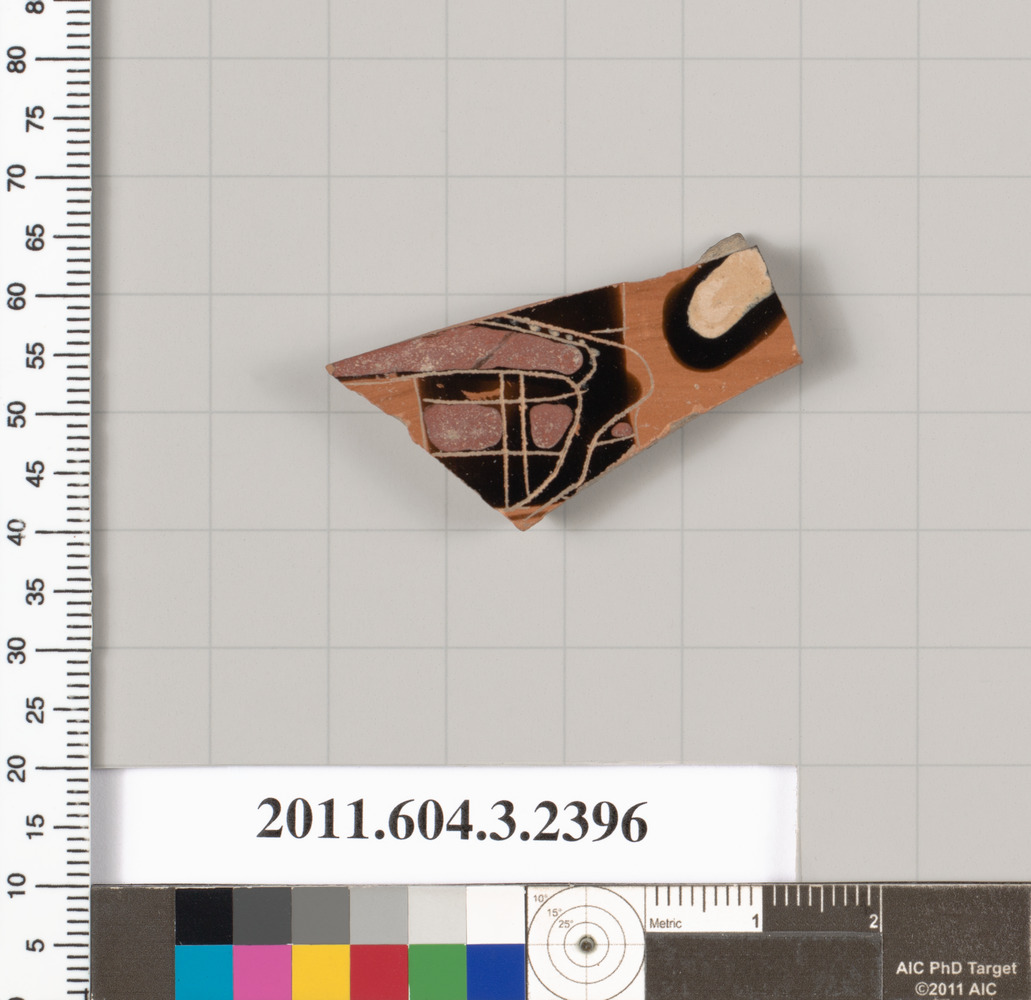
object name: kylix fragment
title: Terracotta fragment of a kylix: eye-cup (drinking cup)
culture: greek, attic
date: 530-510 BCE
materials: terracotta